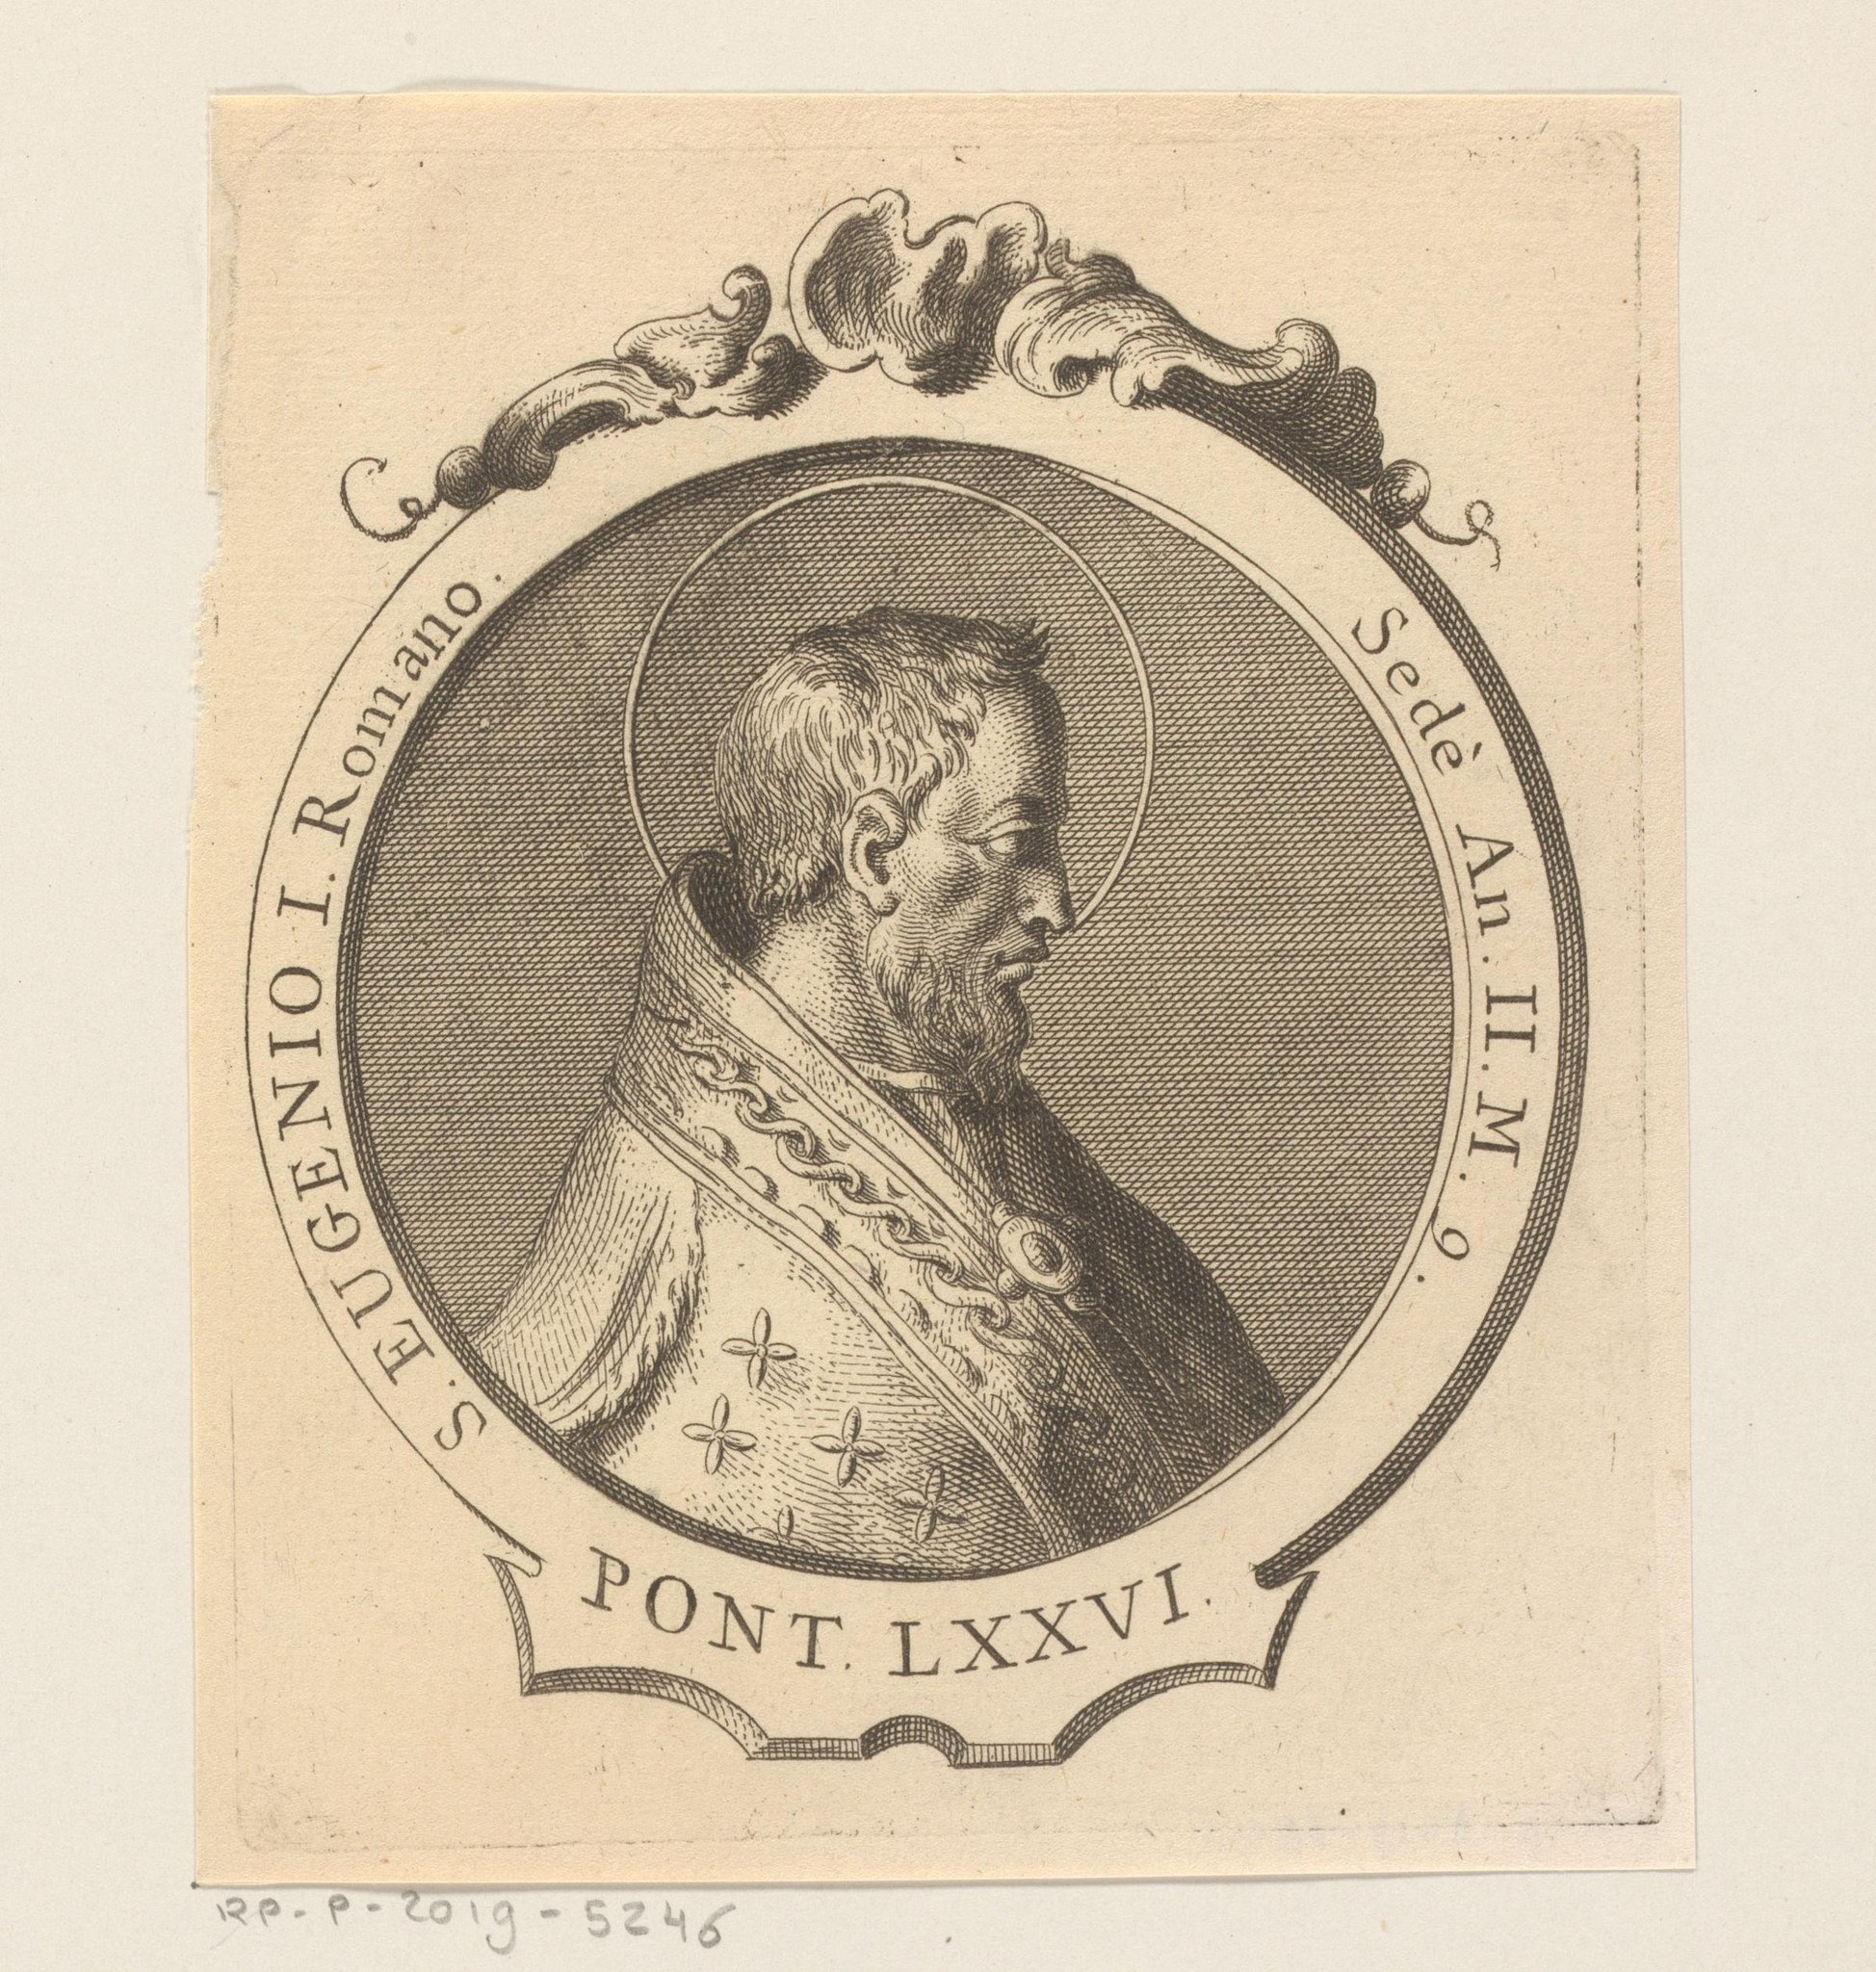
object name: print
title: Portret van paus Eugenius I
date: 1775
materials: paper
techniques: etching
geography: bassano del grappa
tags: rome, historical persons, pope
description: Prent uit: Effigies Romanorum pontificum a S. Petro ad Pium VI. feliciter regnantem (...). 2 dln. Venetië en Bassano del Grappa: Giuseppe Remondini, 1775.